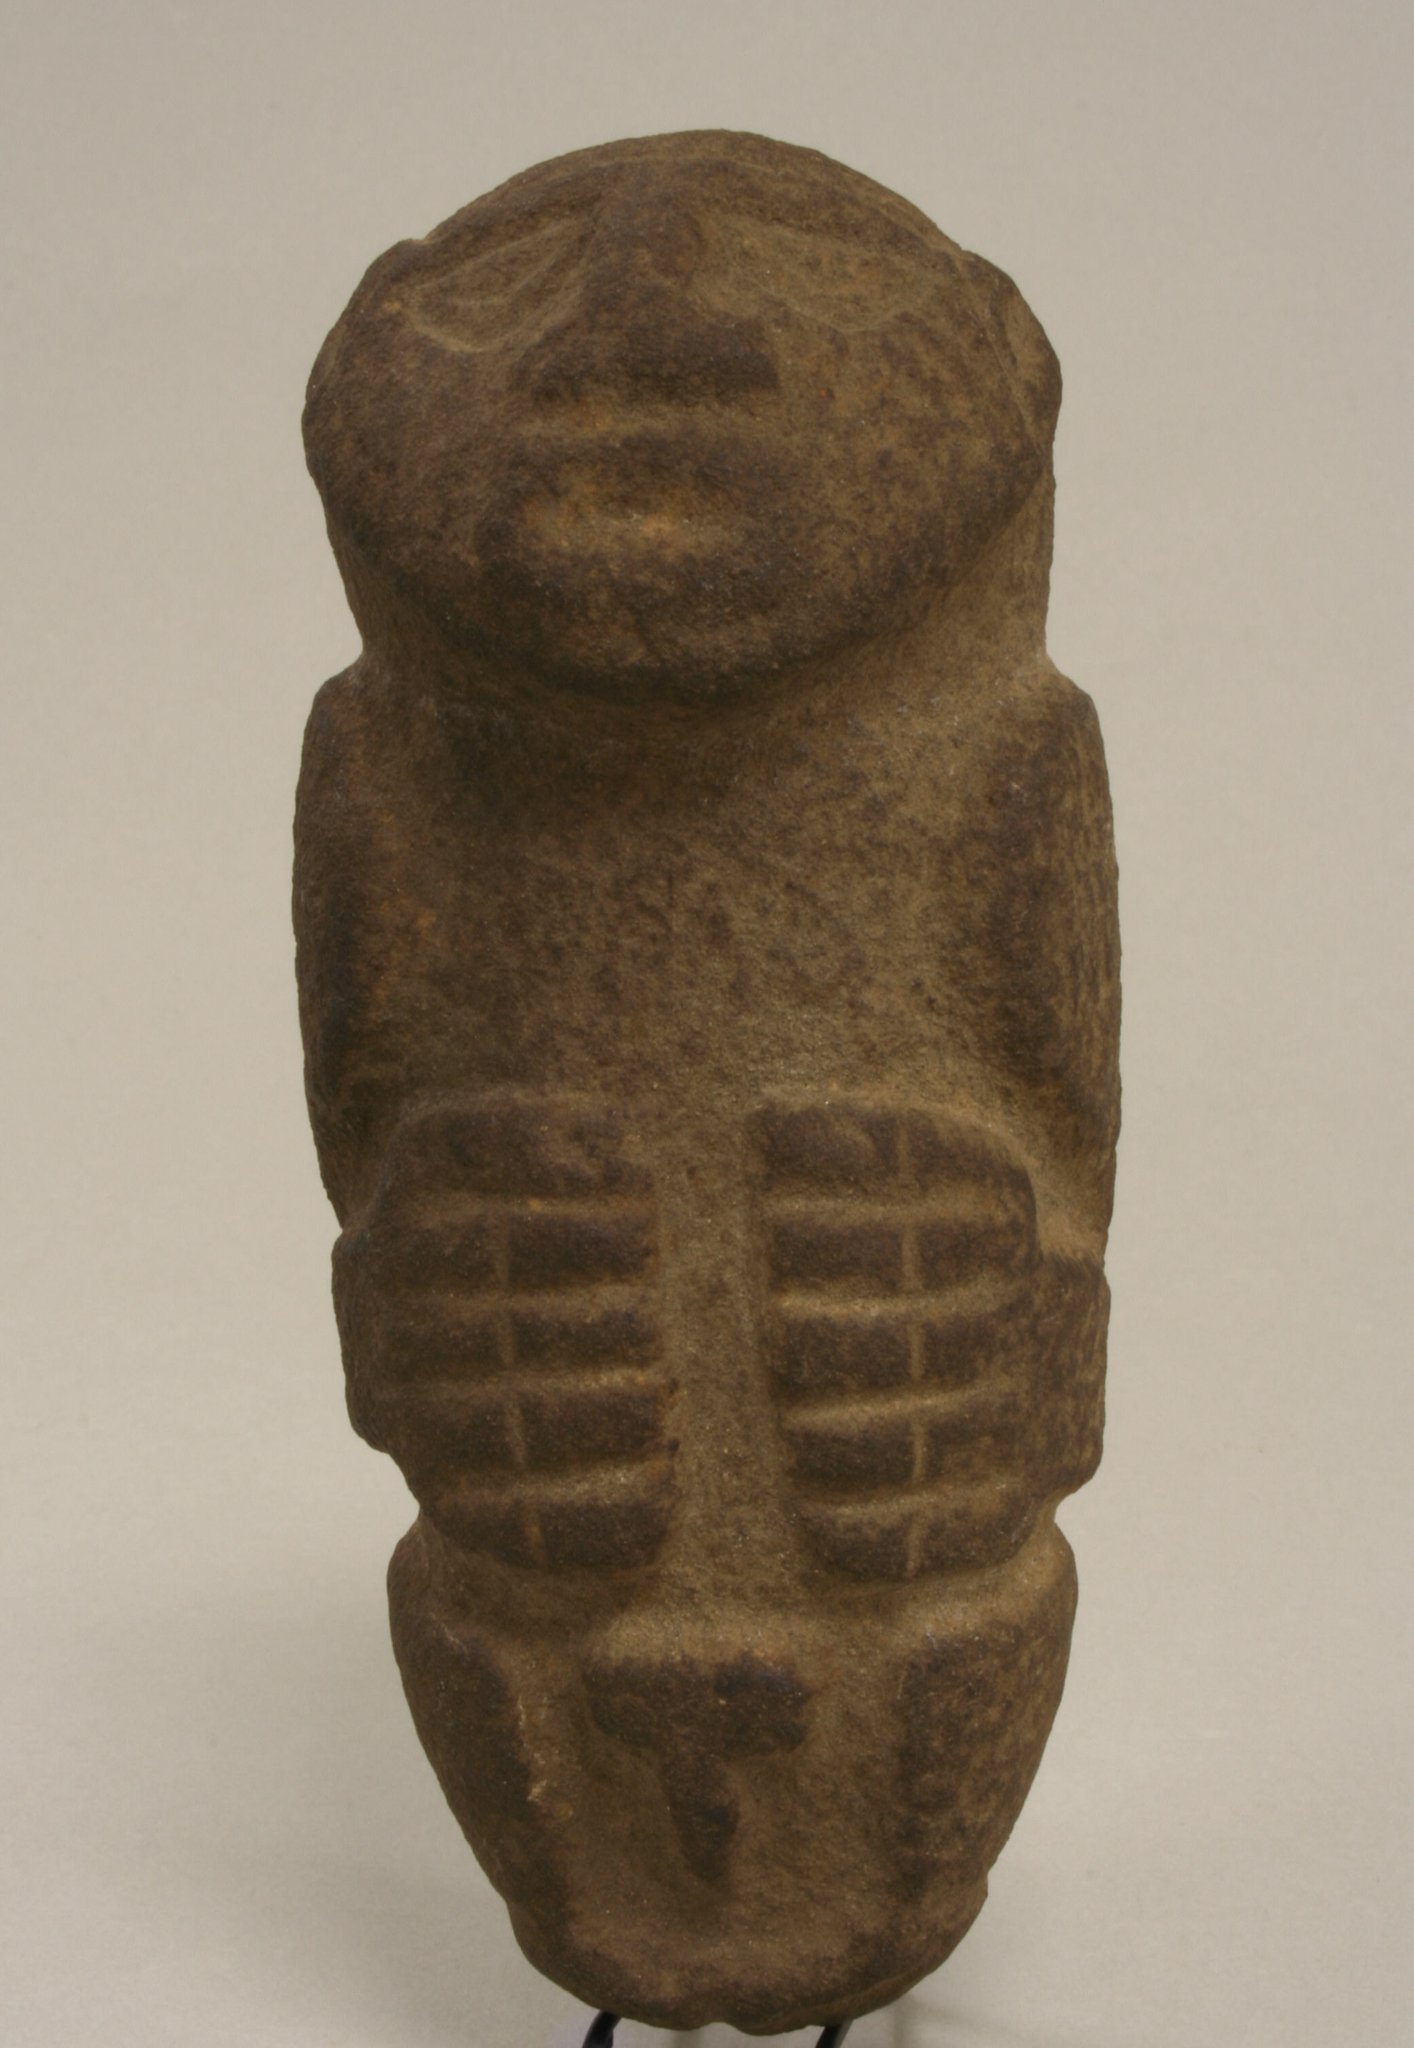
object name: figure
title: Male Figure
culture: atlantic watershed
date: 301-800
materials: stone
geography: costa rica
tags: men